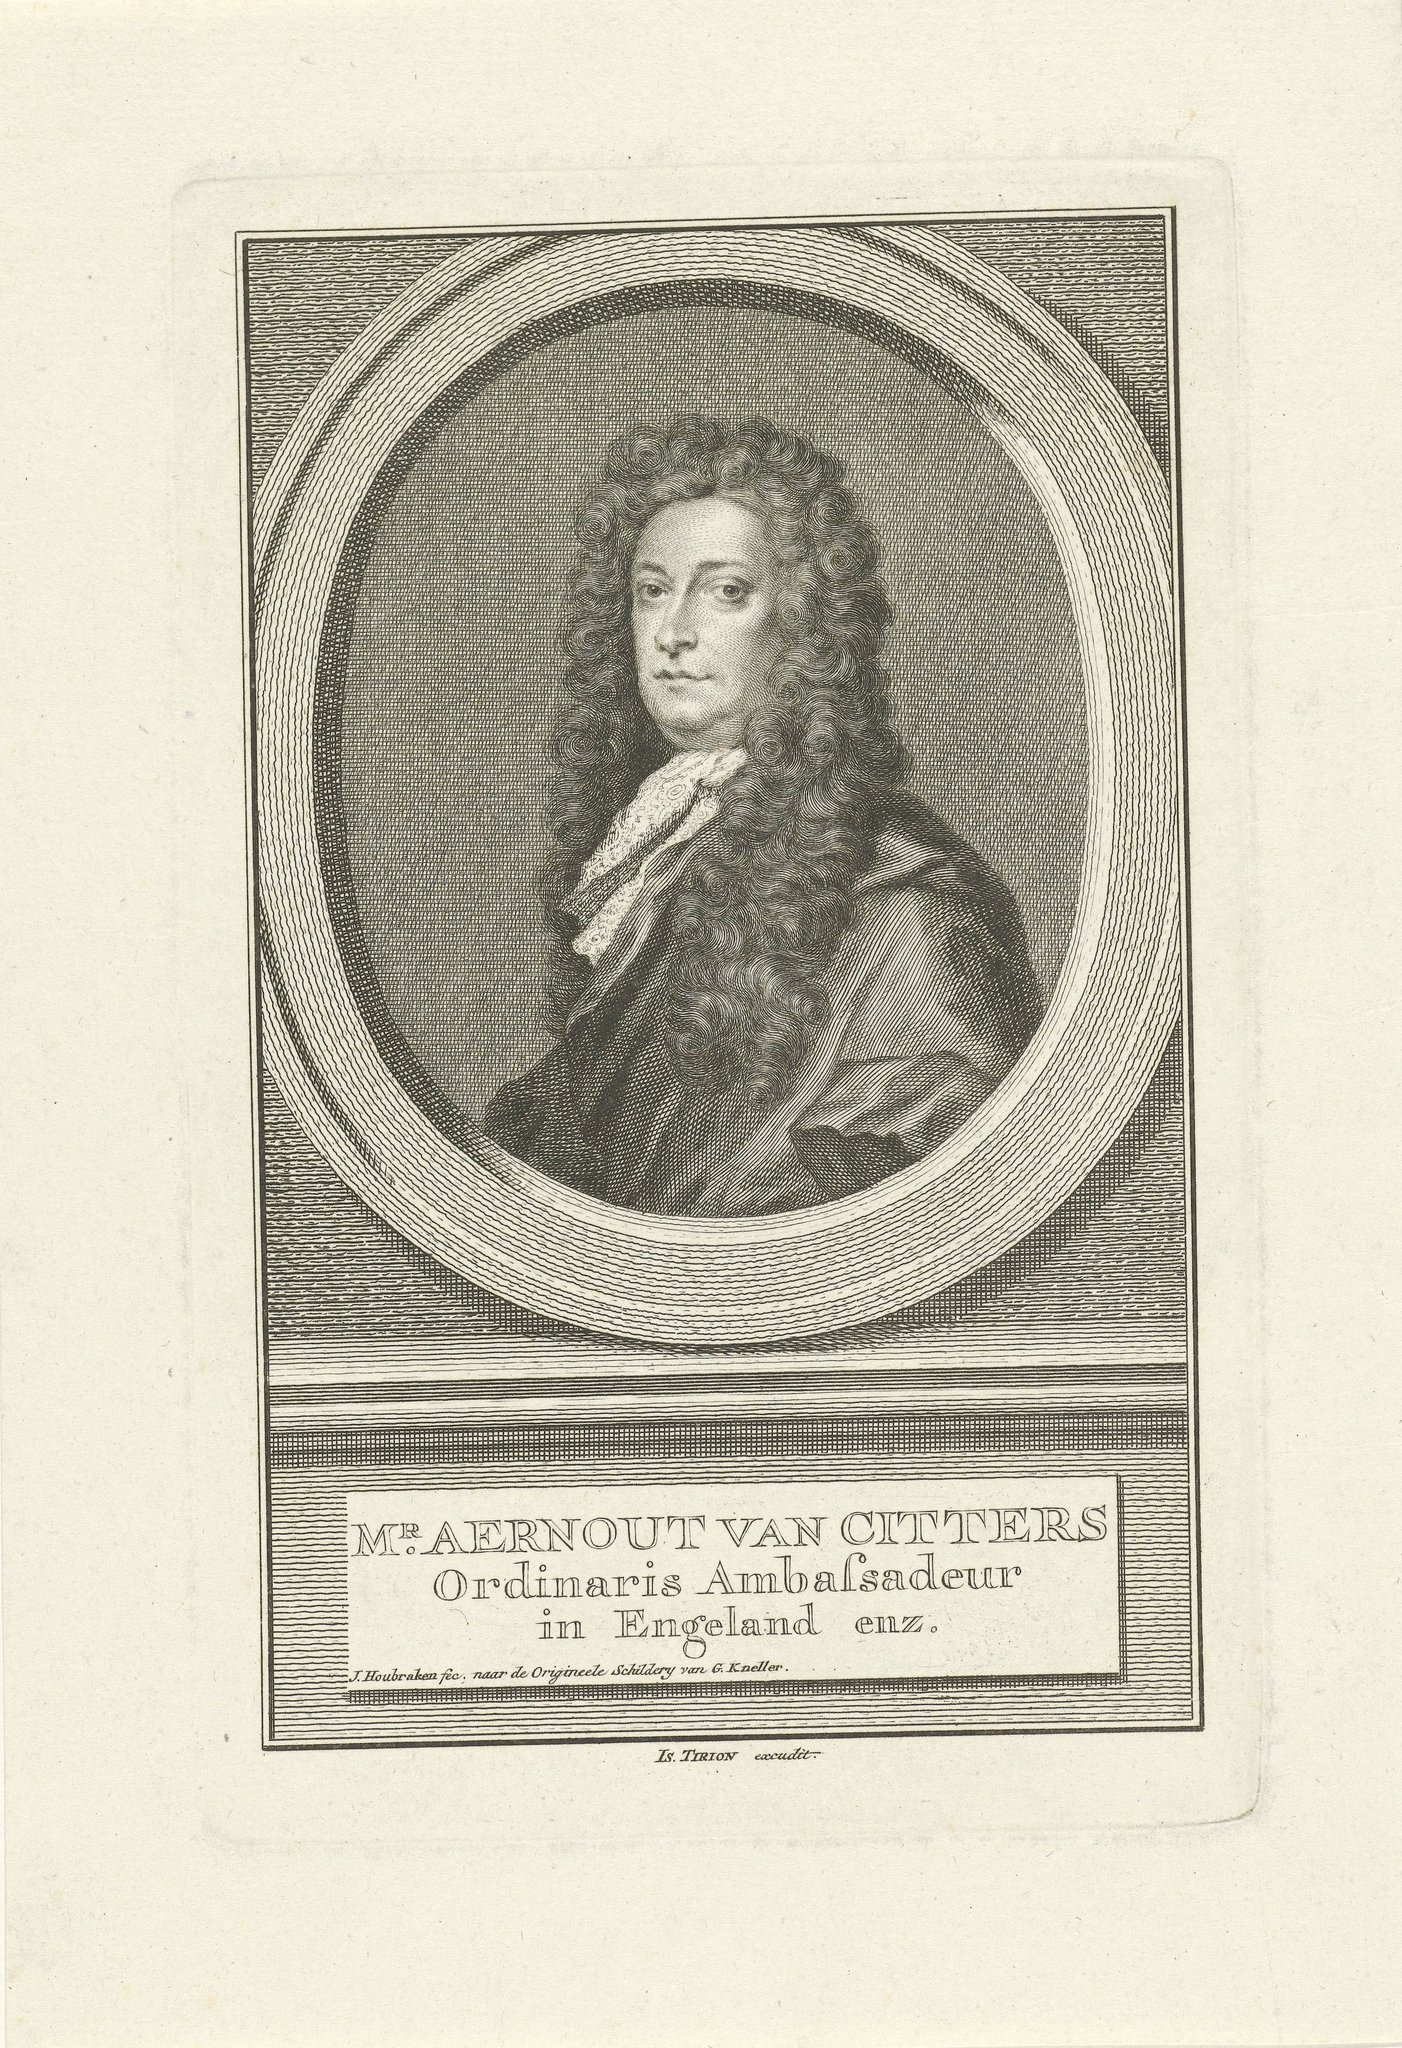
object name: print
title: Mr. Aernout van Citters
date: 1749-1759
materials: paper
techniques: engraving, etching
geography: amsterdam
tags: ambassadeur, aernout van citters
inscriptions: collector's mark: Lugt 2228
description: Prent ook gebruikt in: Jan Wagenaar, Vaderlandsche historie, vervattende de geschiedenissen der nu Vereenigde Nederlanden, inzonderheid die van Holland (...), 21 delen. Amsterdam, Isaak Tirion, 1749-59. Prent volgens Ver Huell ook gebruikt in: Portraiten van eenige der vermaardste staatsmannen en zeehelden, als toevoeging op: Willem Tiberius Hattinga, Atlas van Zeeland. Amsterdam: Isaak Tirion, 1760.